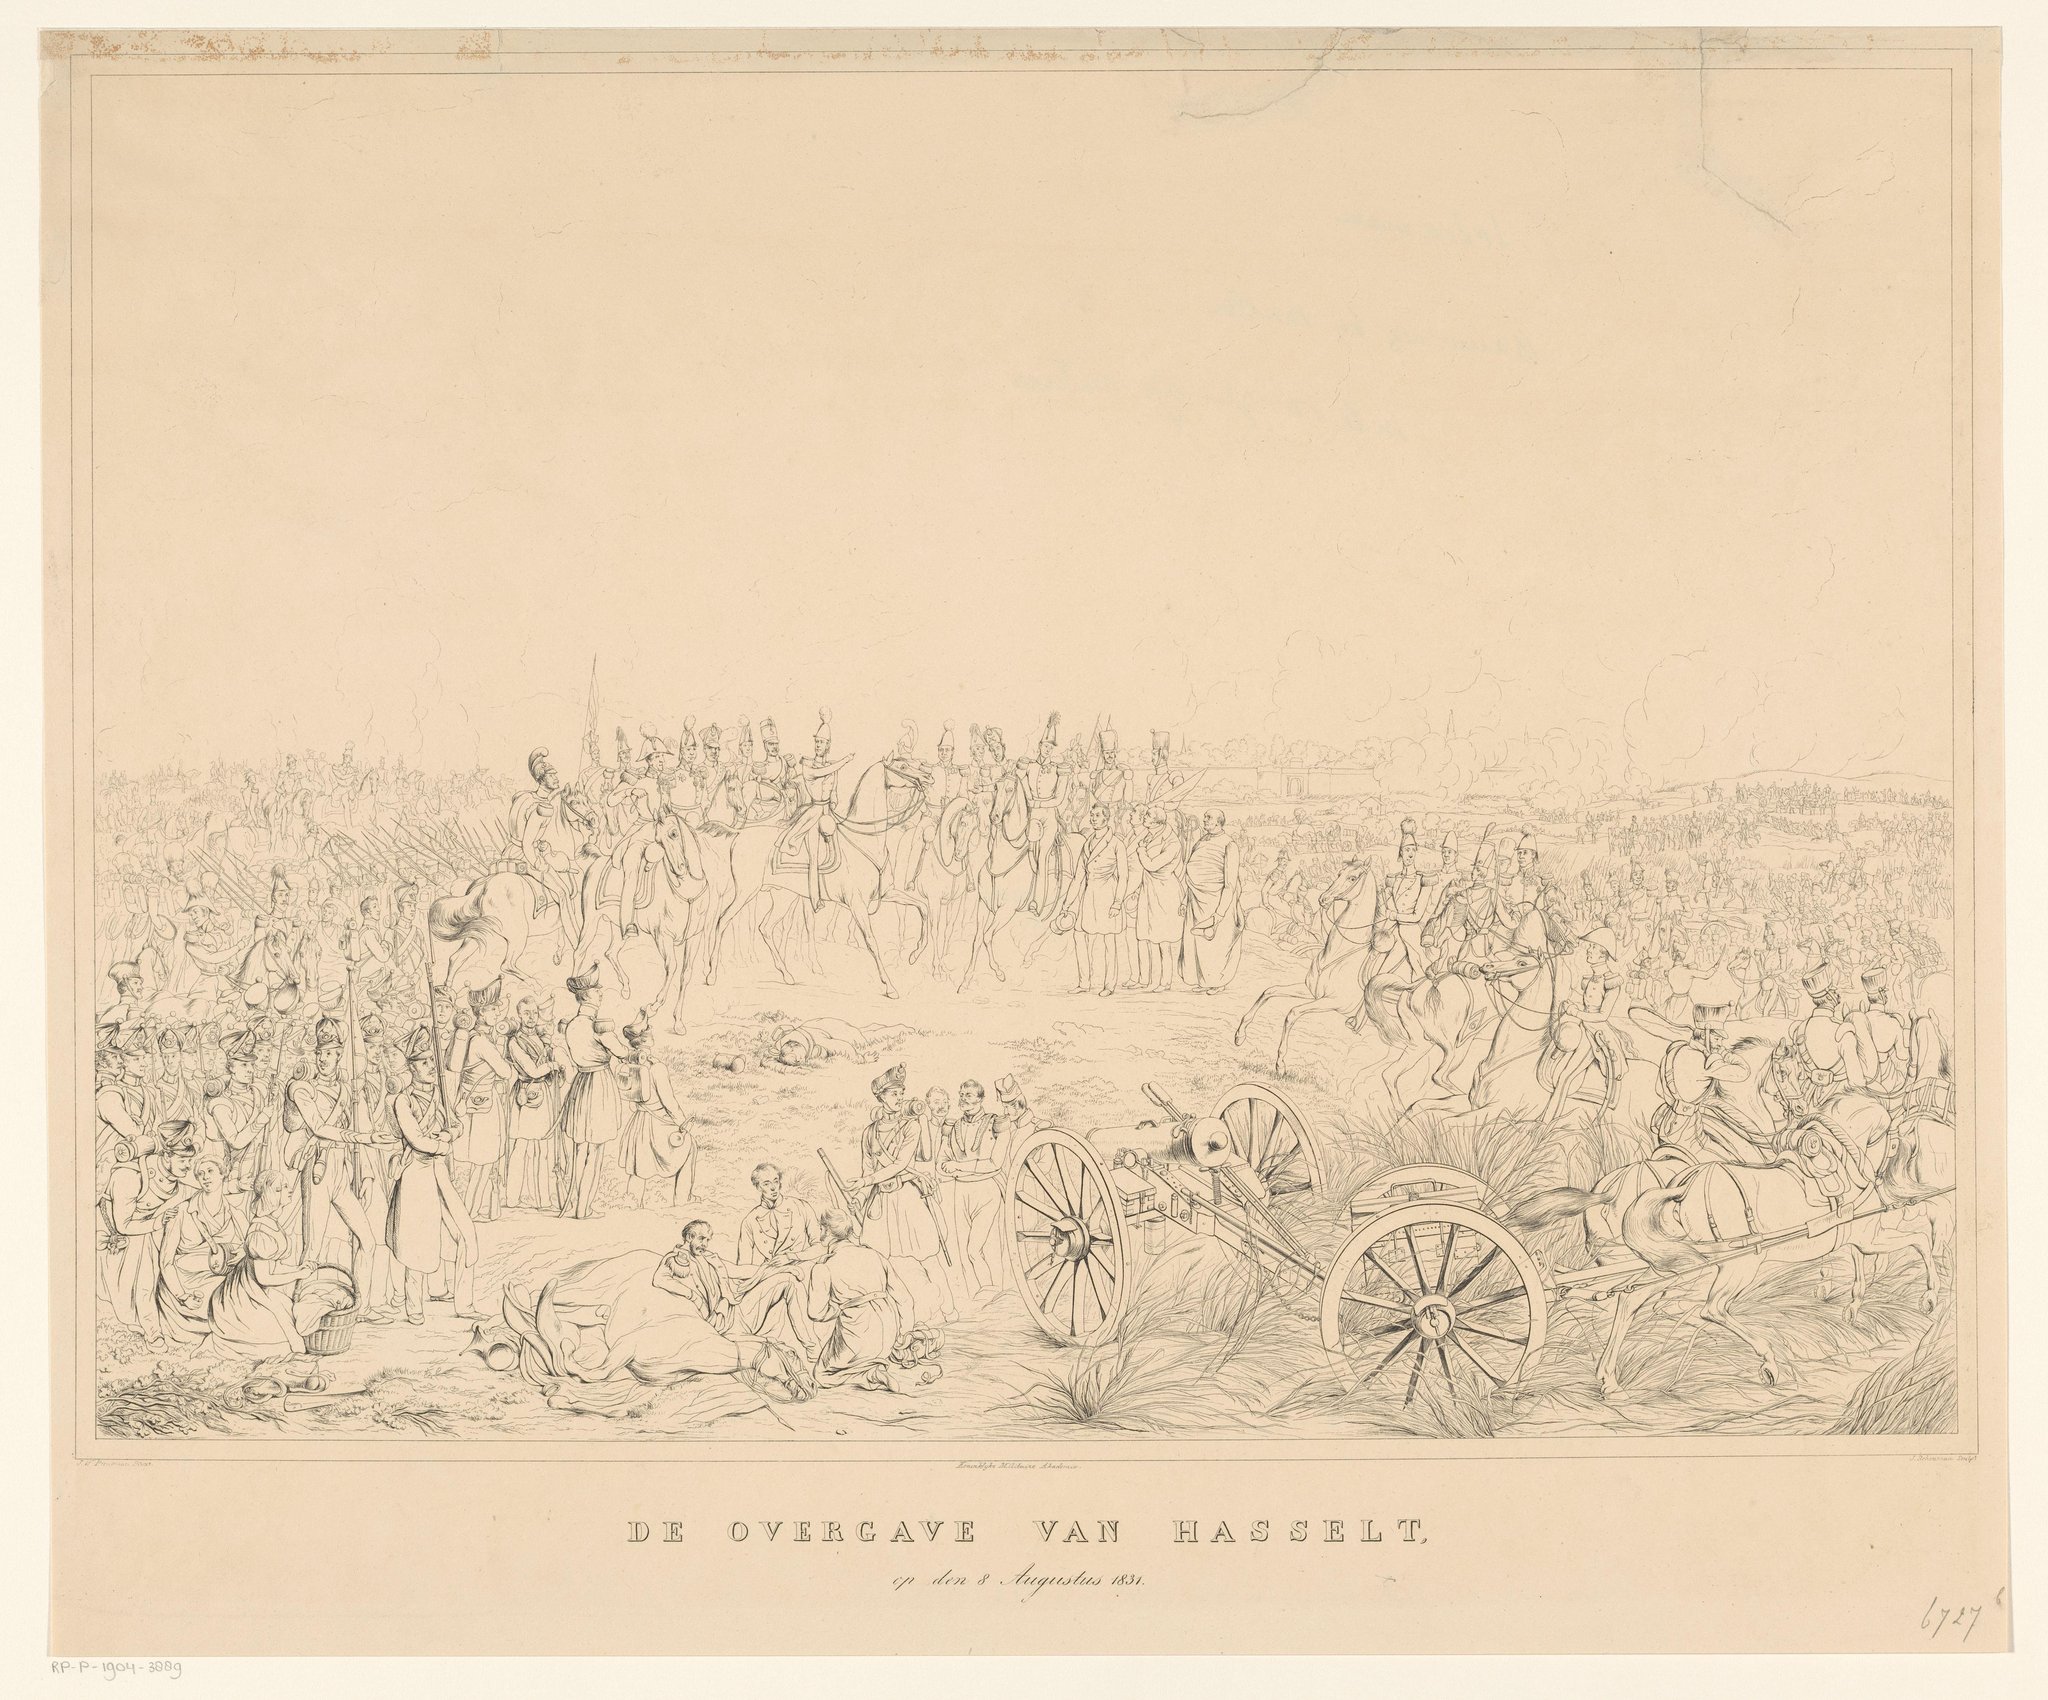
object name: print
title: Overgave van Hasselt op 8 augustus 1831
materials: paper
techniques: lithograph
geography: breda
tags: the hague, william ii of the netherlands, frederik (prins der nederlanden), battle, fighting in general (+ land forces), surrender ~ war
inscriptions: watermark, collector's mark: Lugt 2228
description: De overgave van de stad Hasselt aan de Nederlandse troepen onder bevel van de prins van Oranje, 8 augustus 1831. Gezicht op het slagveld met centraal op een heuvel de prins omringd door zijn staf, allen te paard. Rechts van hen een afvaardiging van de stad Hasselt onder leiding van de burgemeester om over de overgave van de stad te onderhandelen. Rechts prins Frederik tussen enkele officieren. Op de voorgrond wordt een gewonde militair verzorgd. Aan de linkerkant leden van de Leidsche Vrijwillige Jagers en de Jagers van Rookmaker.